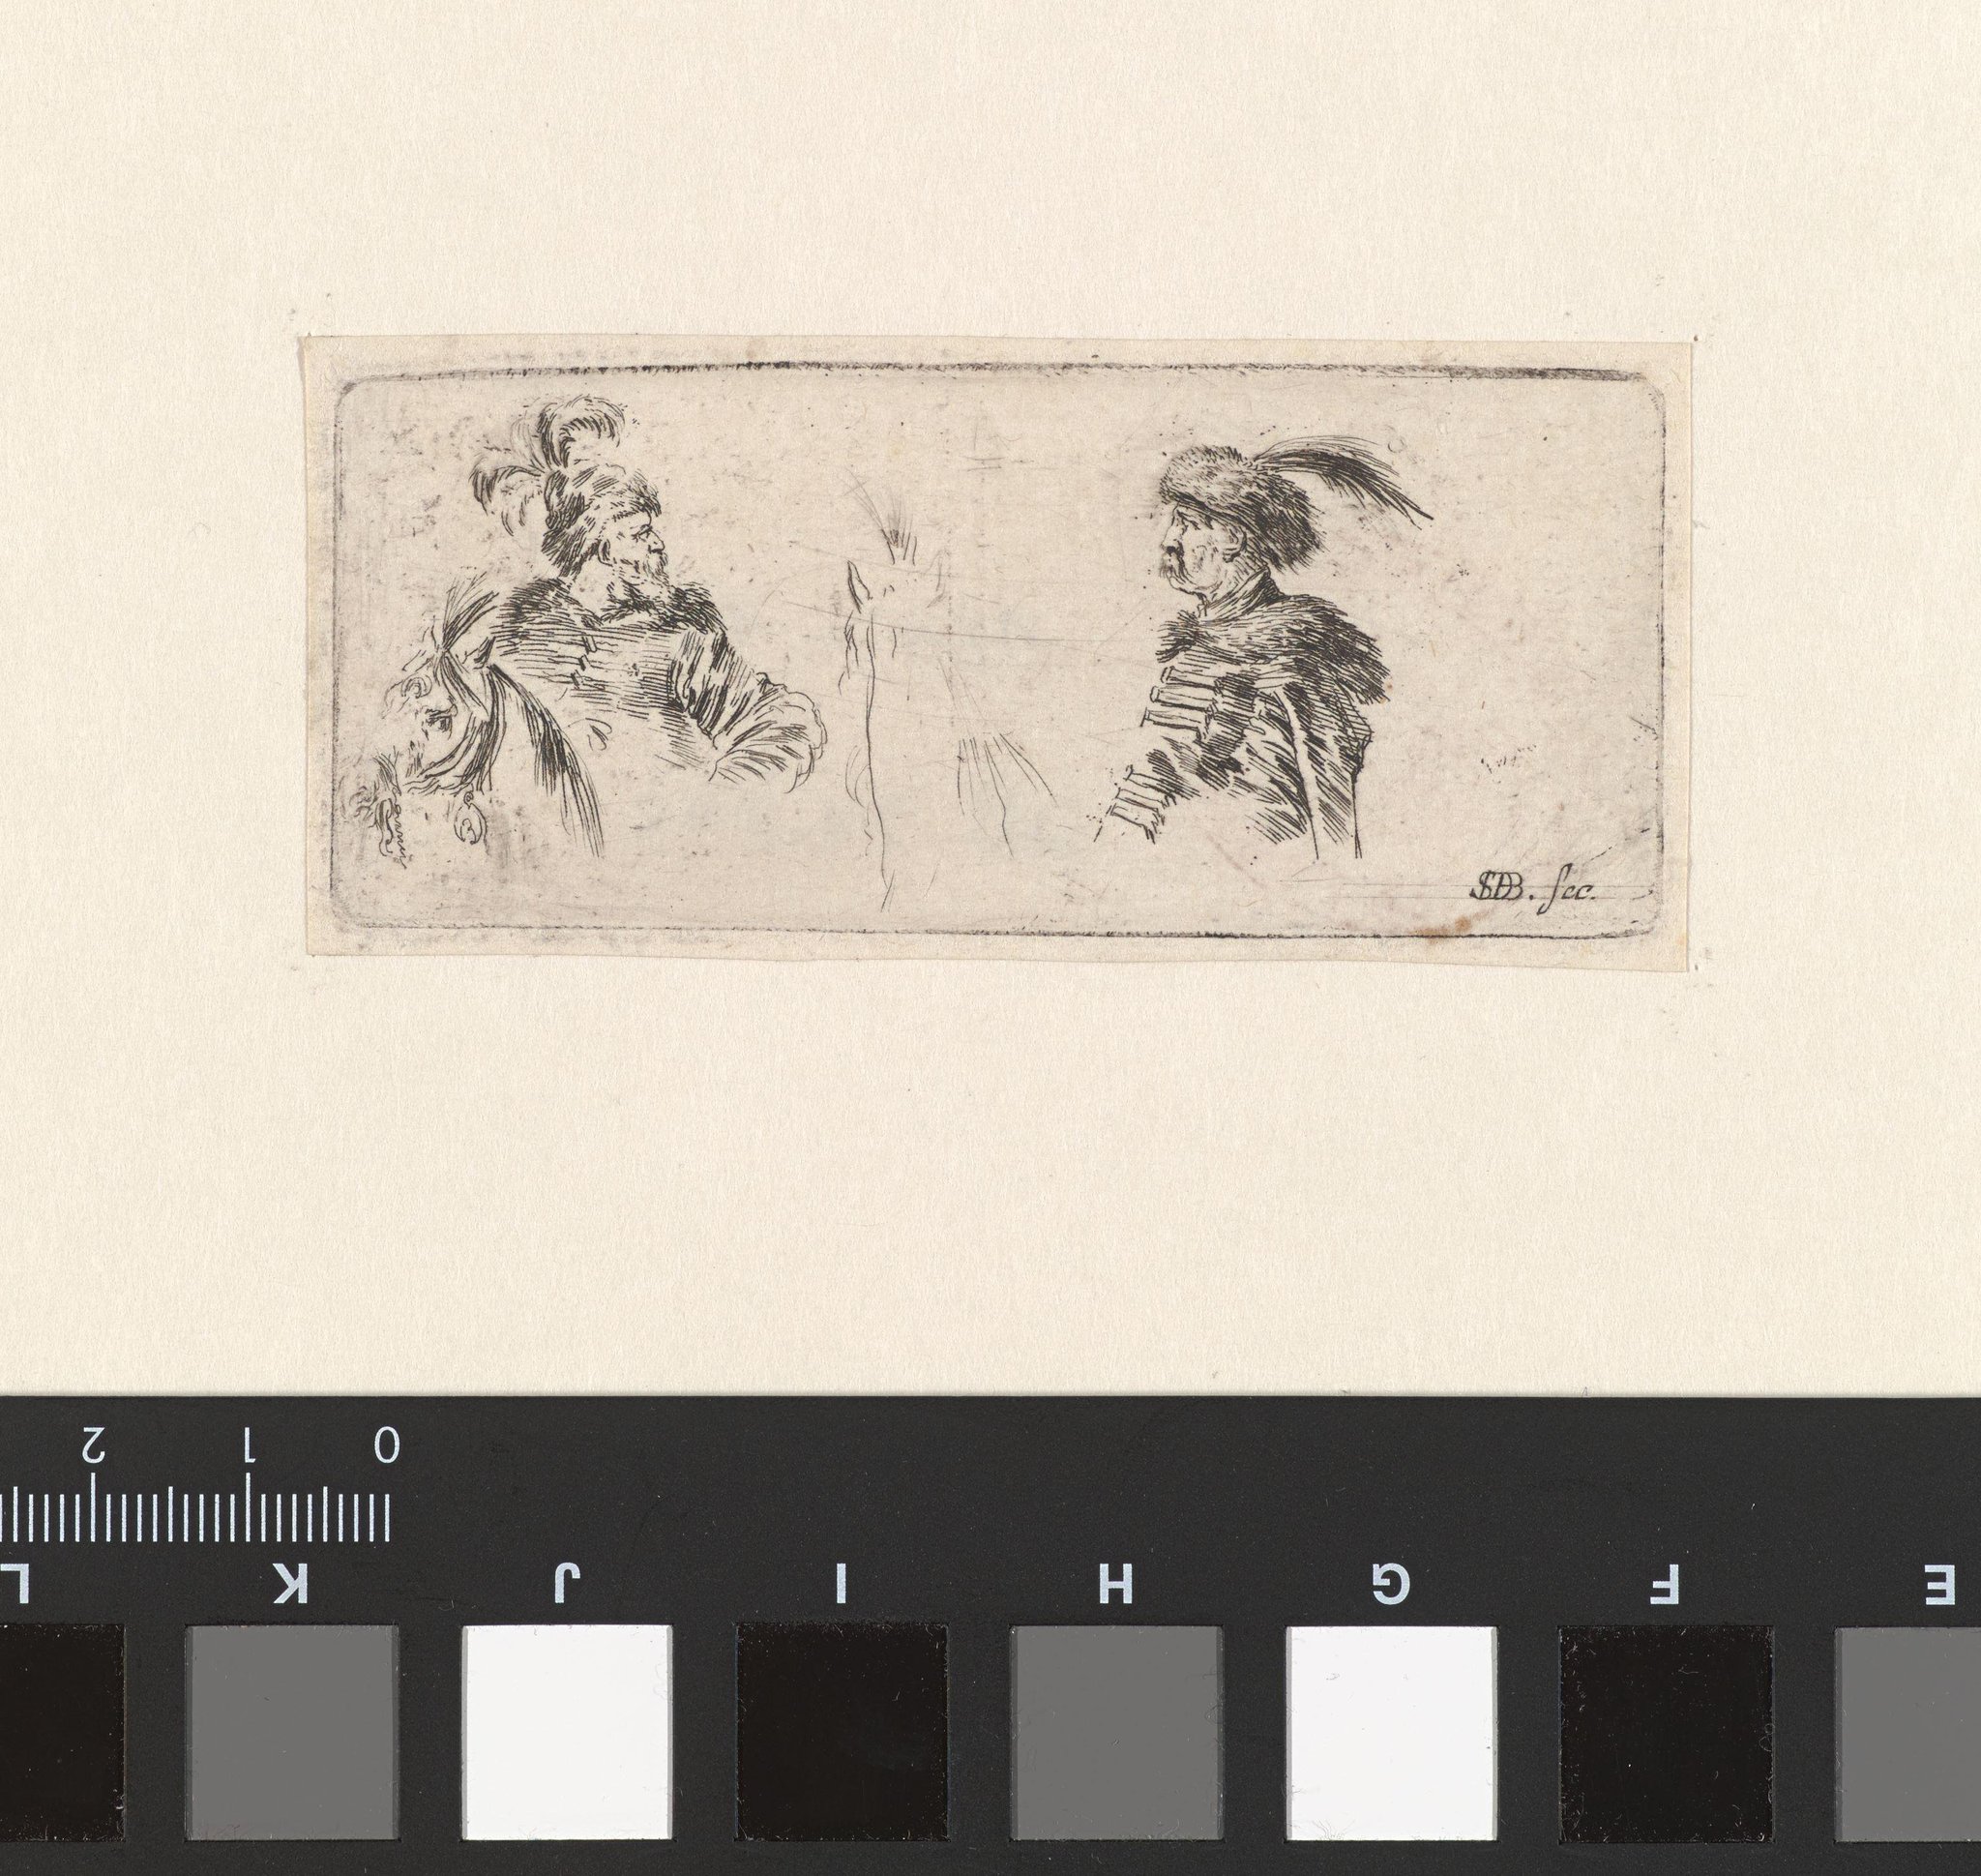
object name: print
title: Recueil de divers griffonnements & preuves d'eau forte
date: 1620-1657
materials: paper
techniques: etching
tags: riding a horse, ass, or mule; rider, horseman, adult man, horse, head-gear: hat (+ feathers used for clothes)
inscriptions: collector's mark: Lugt 240